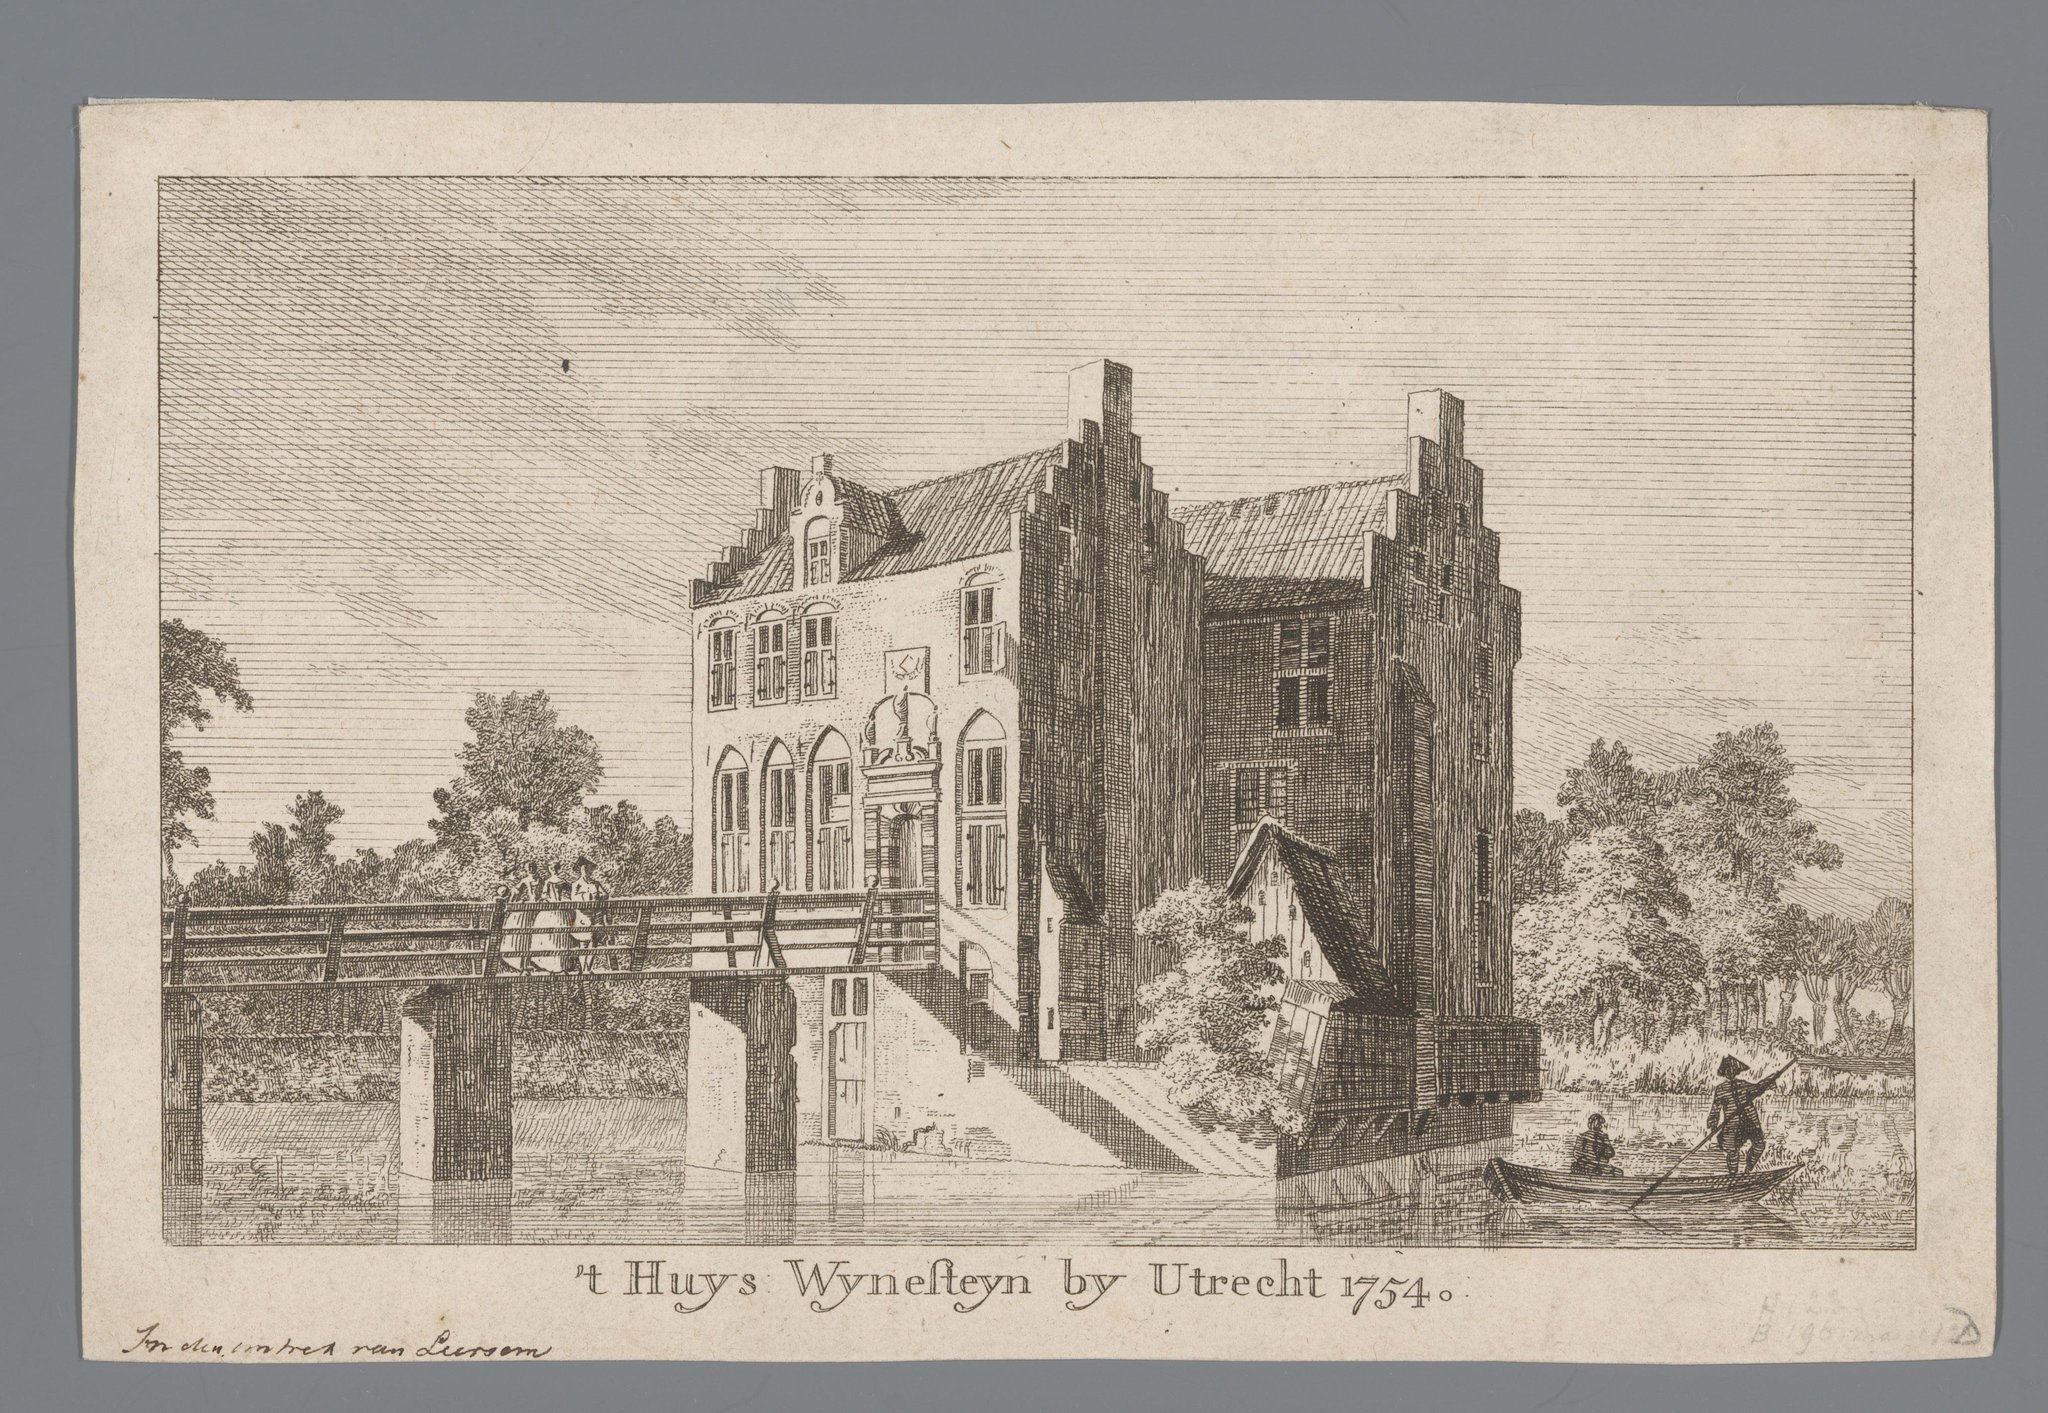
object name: print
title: 't Huys Wynesteyn by Utrecht 1754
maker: Anonymous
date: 1754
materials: paper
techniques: etching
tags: castle, landscape with tower or castle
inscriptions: date